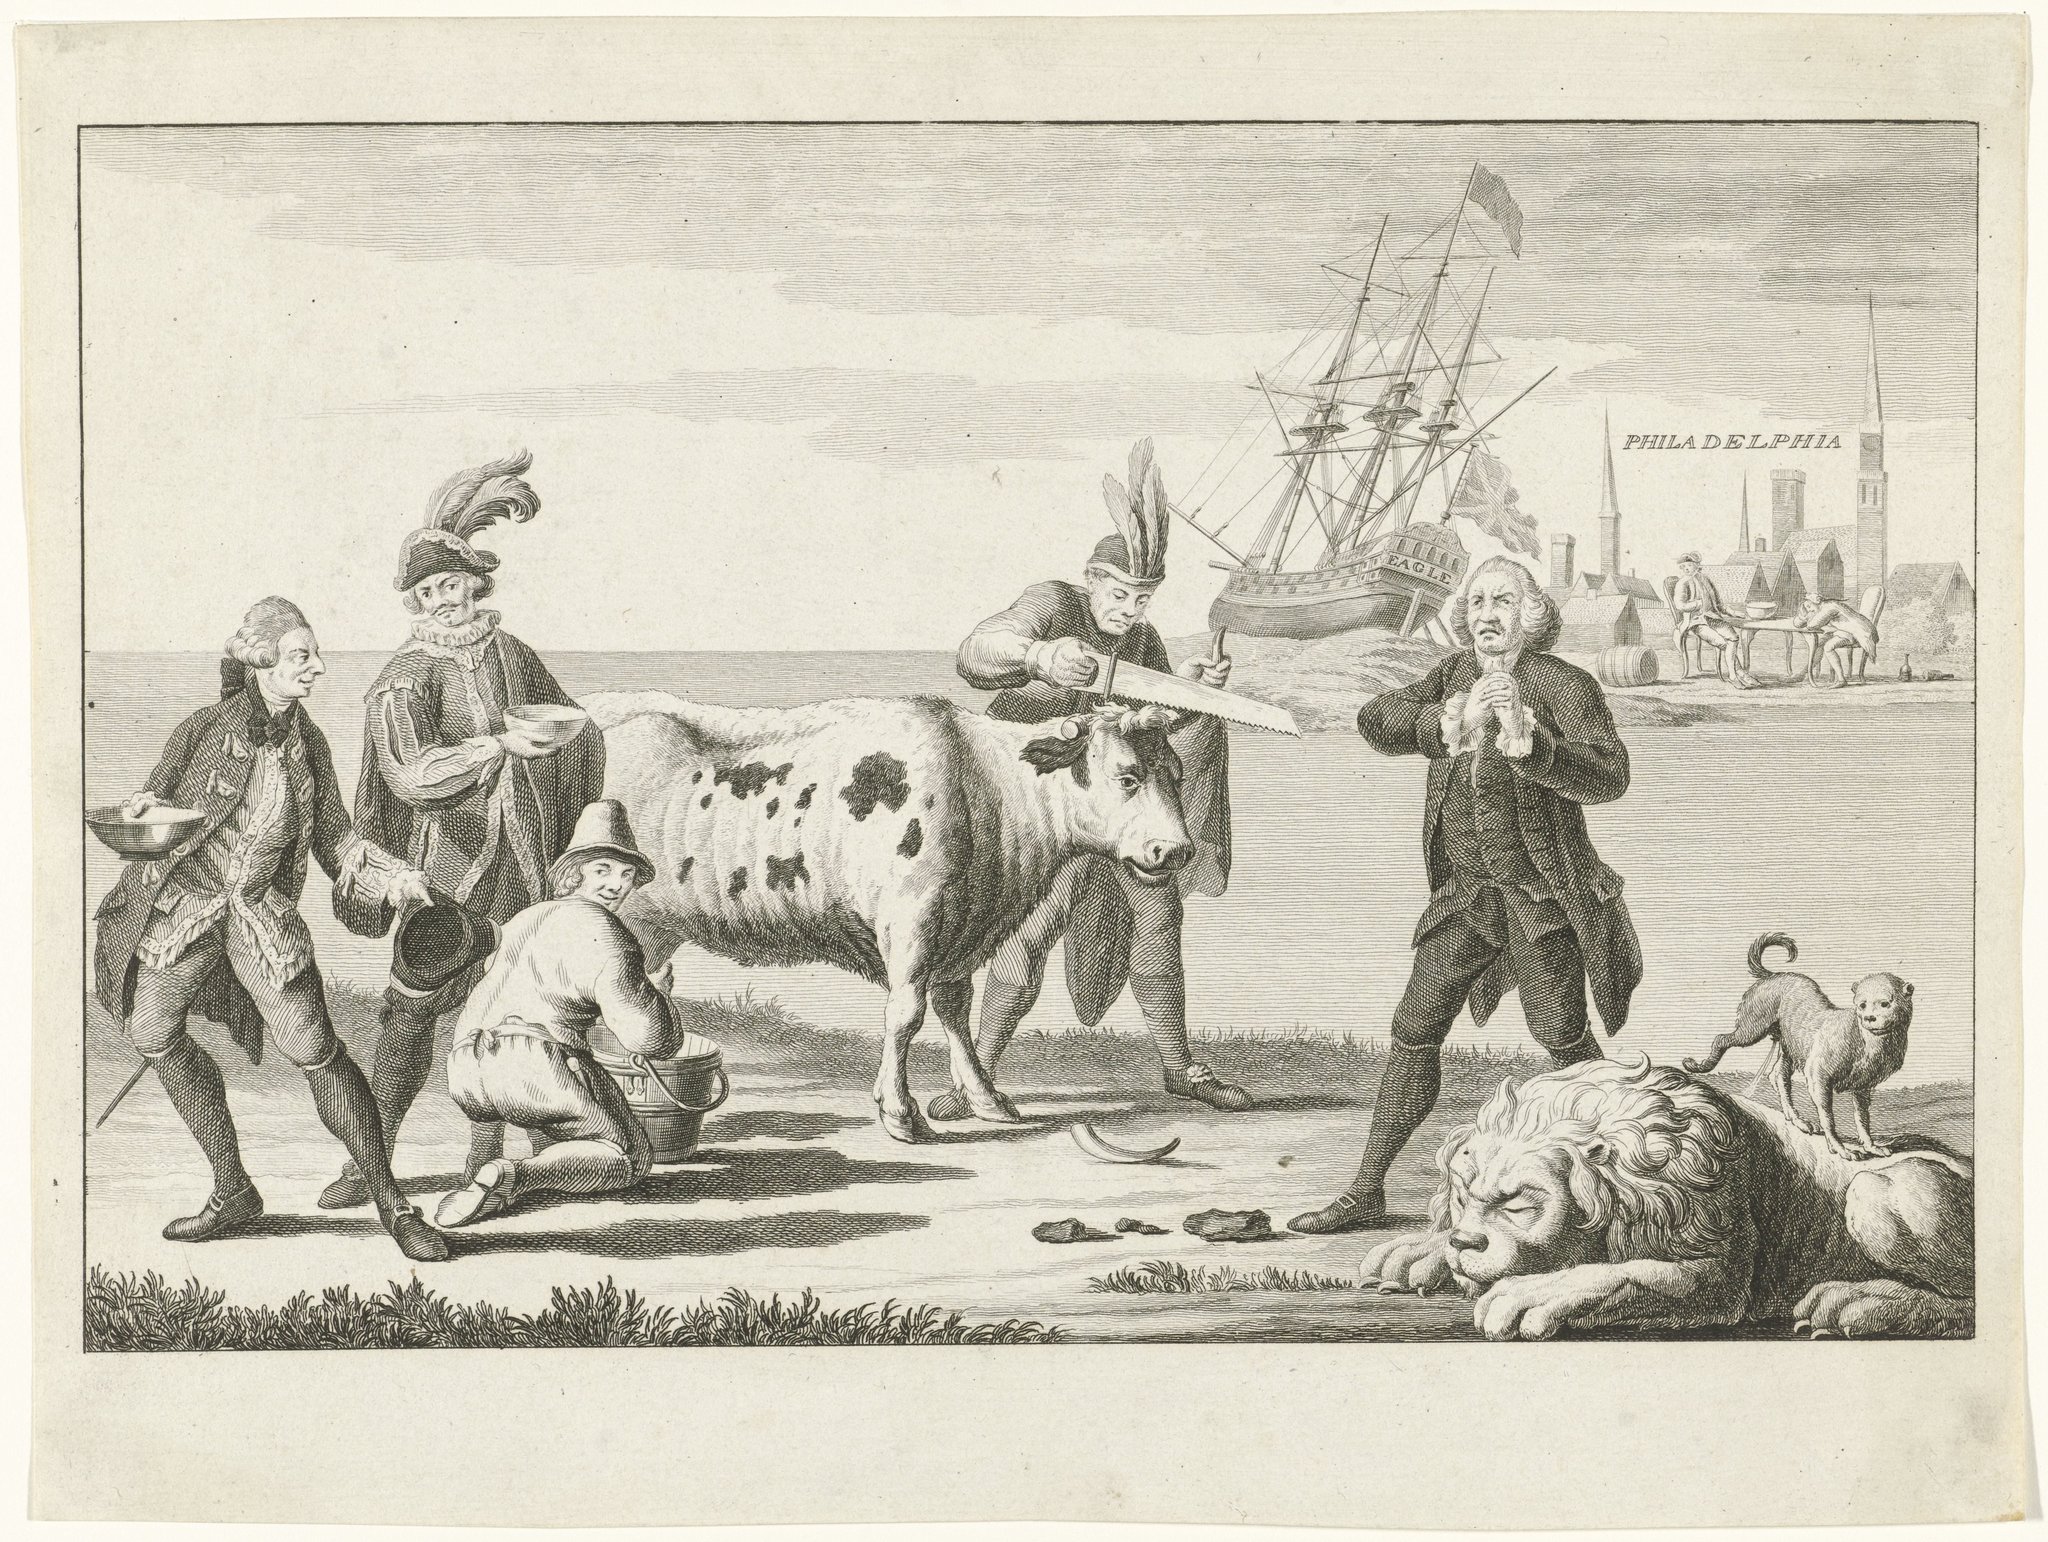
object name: cartoon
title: Spotprent op de Engelse verliezen in de strijd met Amerika (1), 1778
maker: Anonymous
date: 1778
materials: paper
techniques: engraving, etching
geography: northern netherlands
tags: cow, political caricatures and satires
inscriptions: collector's mark: Lugt 2228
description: Eerste spotprent op de Engelse verliezen in de strijd met Amerika in 1778. De Engelse koophandel verbeeld door een melkkoe waarvan het Amerikaanse Congres de horens afzaagt en die door een Hollander wordt gemolken. Een Fransman en een Spanjaard willen ook van het melk hebben. Op de achtergrond het door de Amerikanen veroverde en onttakelde Engelse schip de Eagle (17 september 1778) gestrand nabij Philadelphia. Op de voorgrond pist een hondje (een Steendogge) op de slapende Britse leeuw, hierbij een handenwringende Engelsman in rouwgewaad. Bij de prent behoort een tekstblad met een uitleg van de voorstelling.